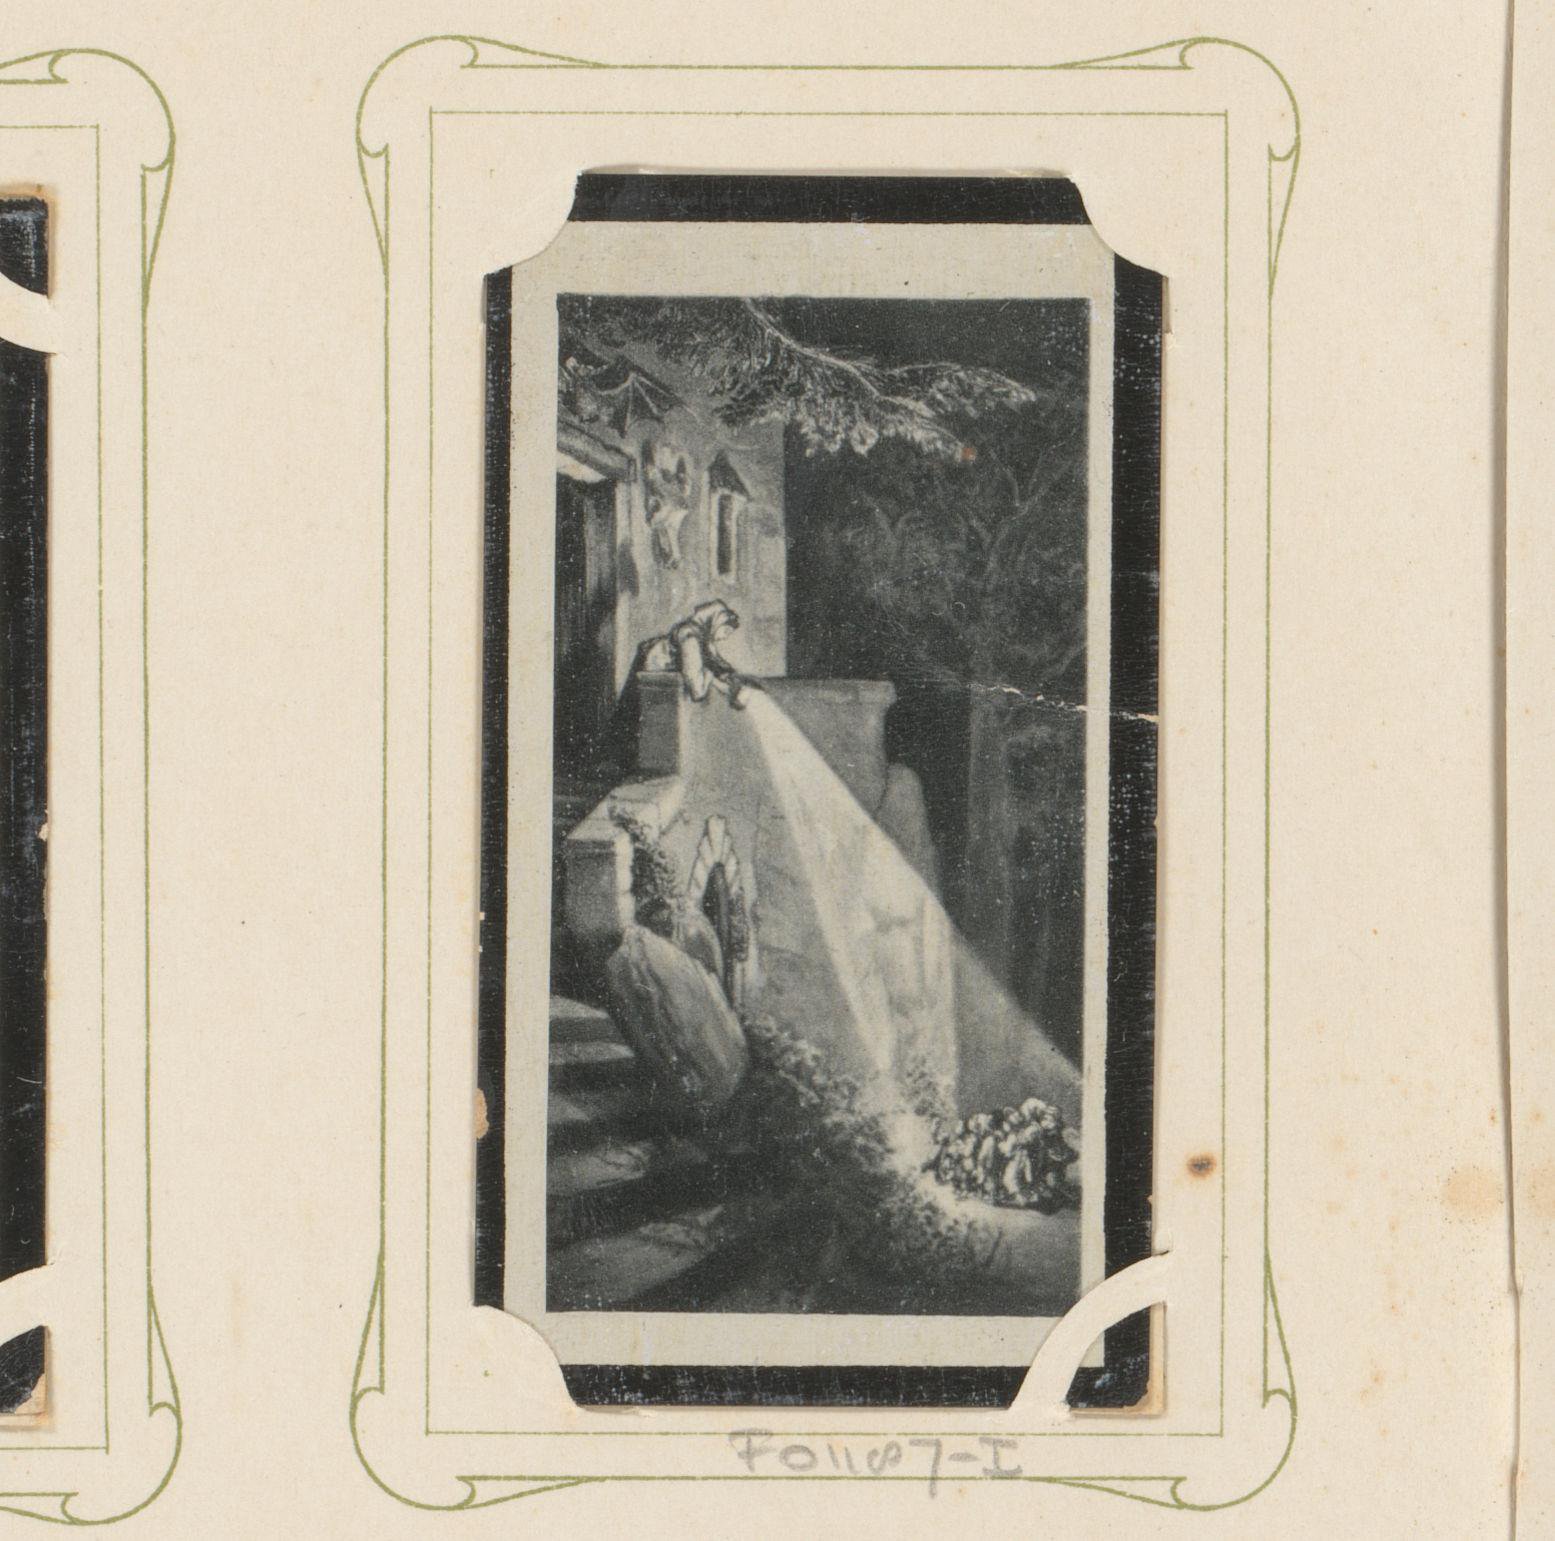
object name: album leaf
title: Reproductie van een tekening van Klein Duimpje en een groep kinderen voor het huis van de reus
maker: Anonymous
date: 1905-1906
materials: paper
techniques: photograph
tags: child (+ more than eight persons), rural housing, e.g. country-house, villa, cottage, tales and fairy tales: little thumbling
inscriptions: inscription: ‘No. 3./ Voor het huis van den reus.’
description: Deze prent maakt deel uit van een album.